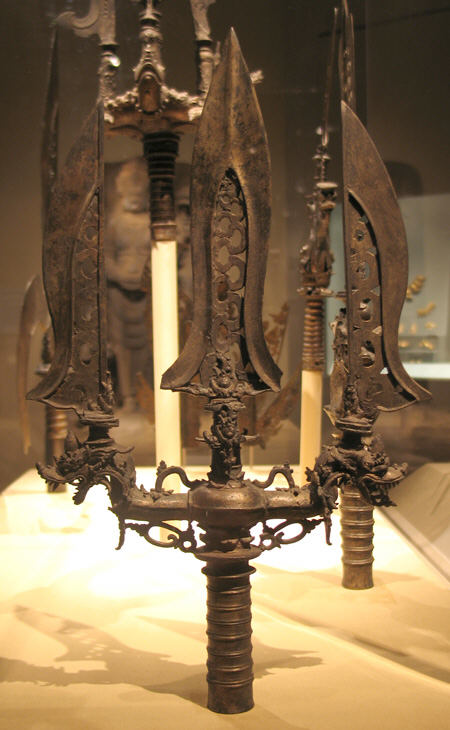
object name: halberd head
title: Halberd Head with Nagas and Blades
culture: indonesian, javanese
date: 1251-1300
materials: copper alloy